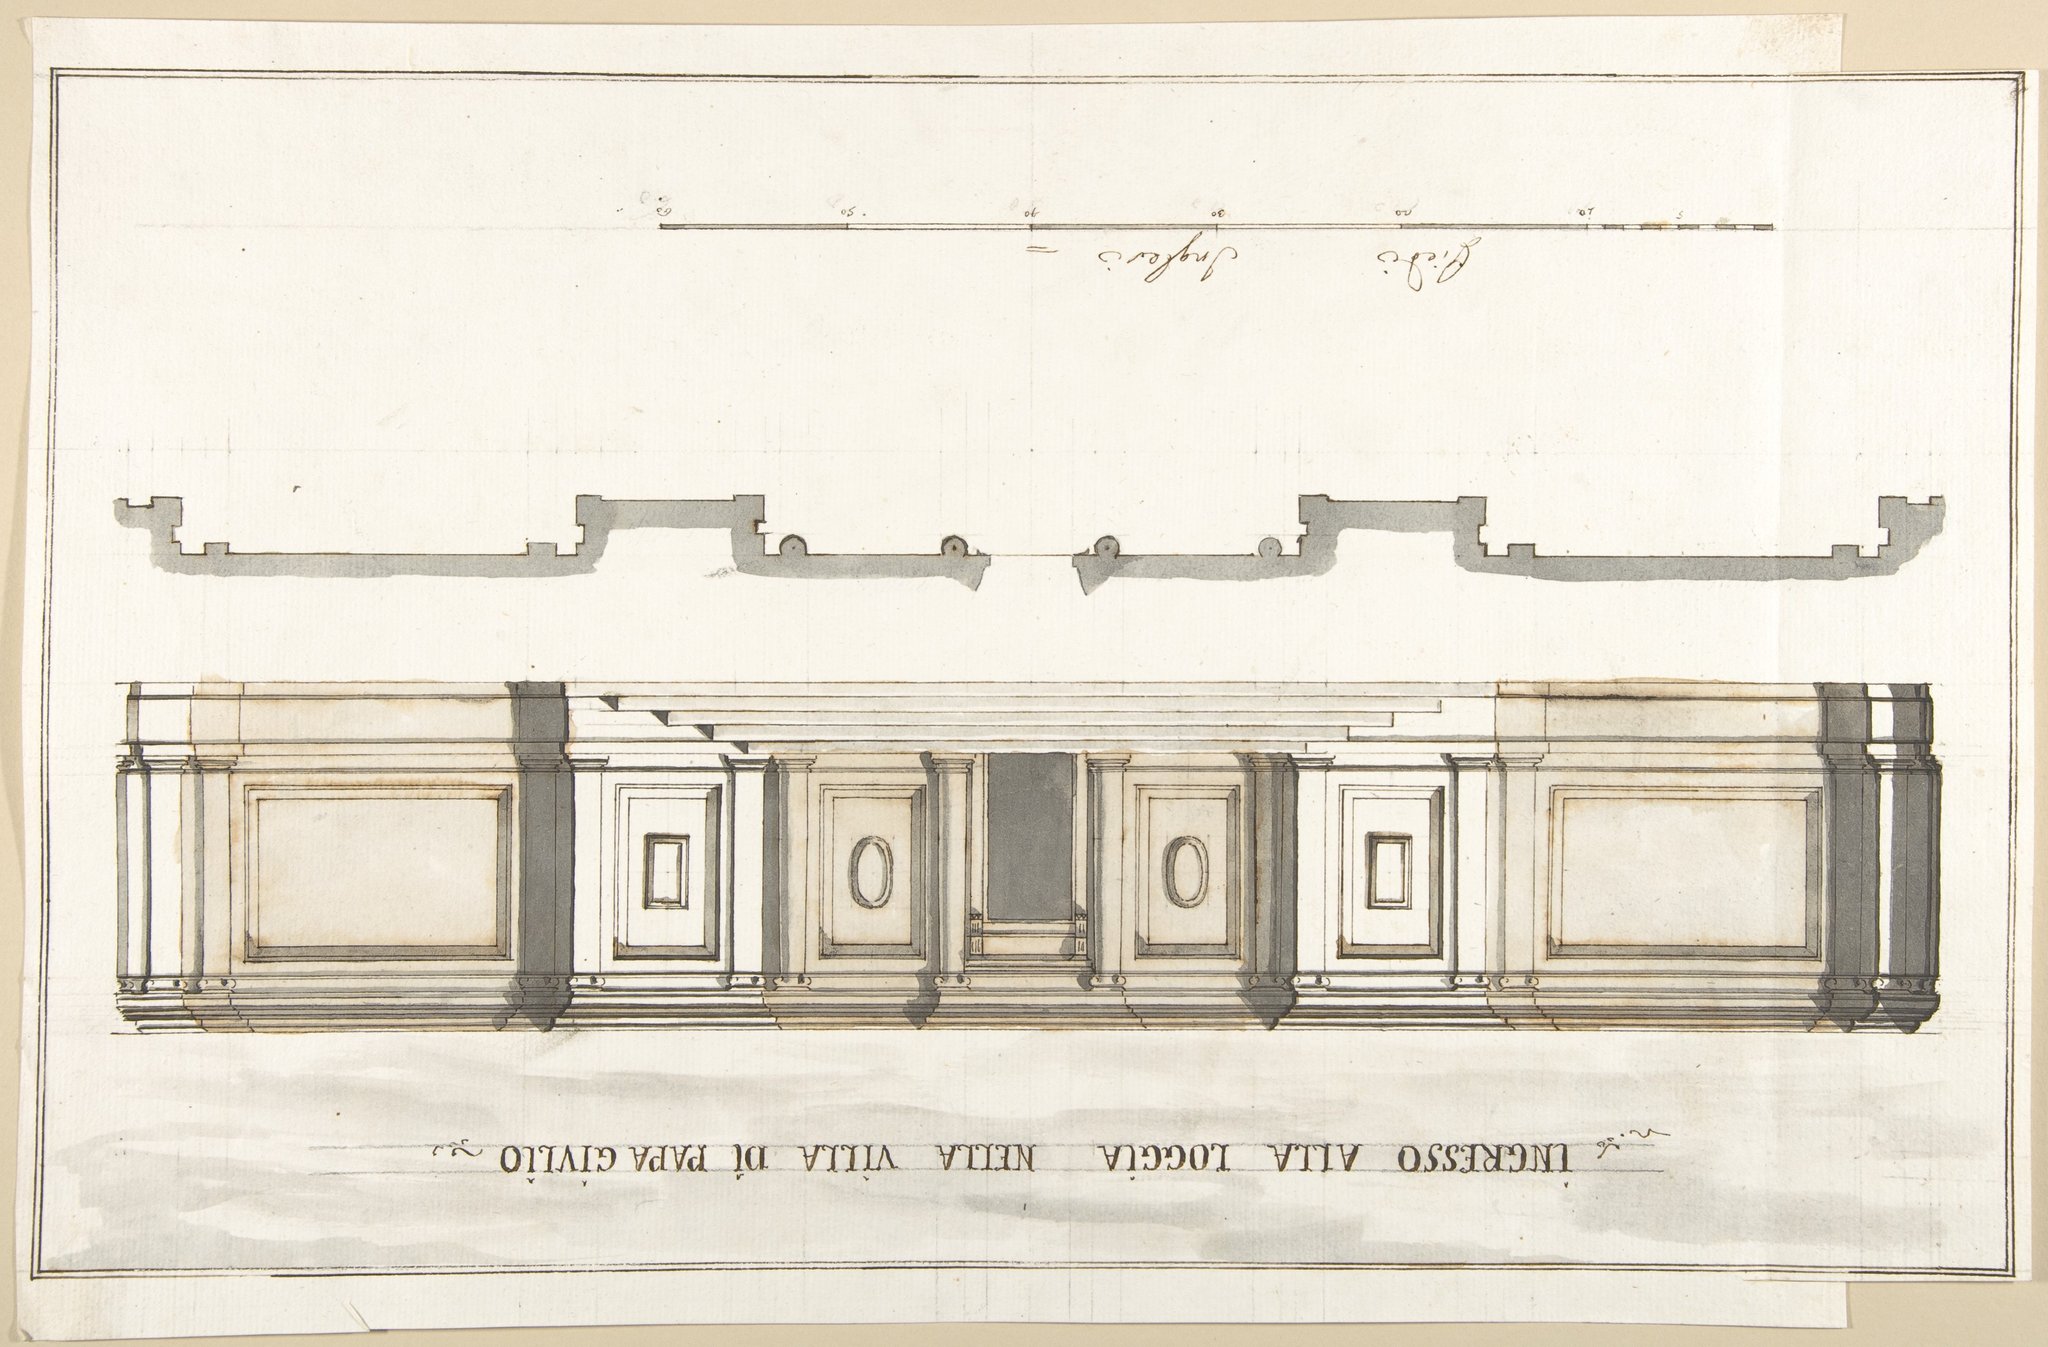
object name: drawing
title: Design for the Entrance of the Loggia of the Villa of Pope Julius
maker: pietro paolo coccetti (cocchetti)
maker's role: artist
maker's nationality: italian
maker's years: 1710-1727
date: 1710-1727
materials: graphite, ink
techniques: brush, pen, wash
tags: architecture